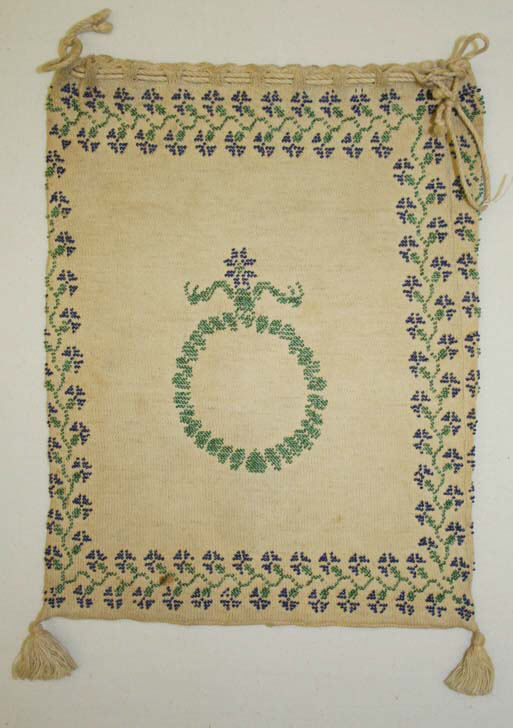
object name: bag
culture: european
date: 1800-1820